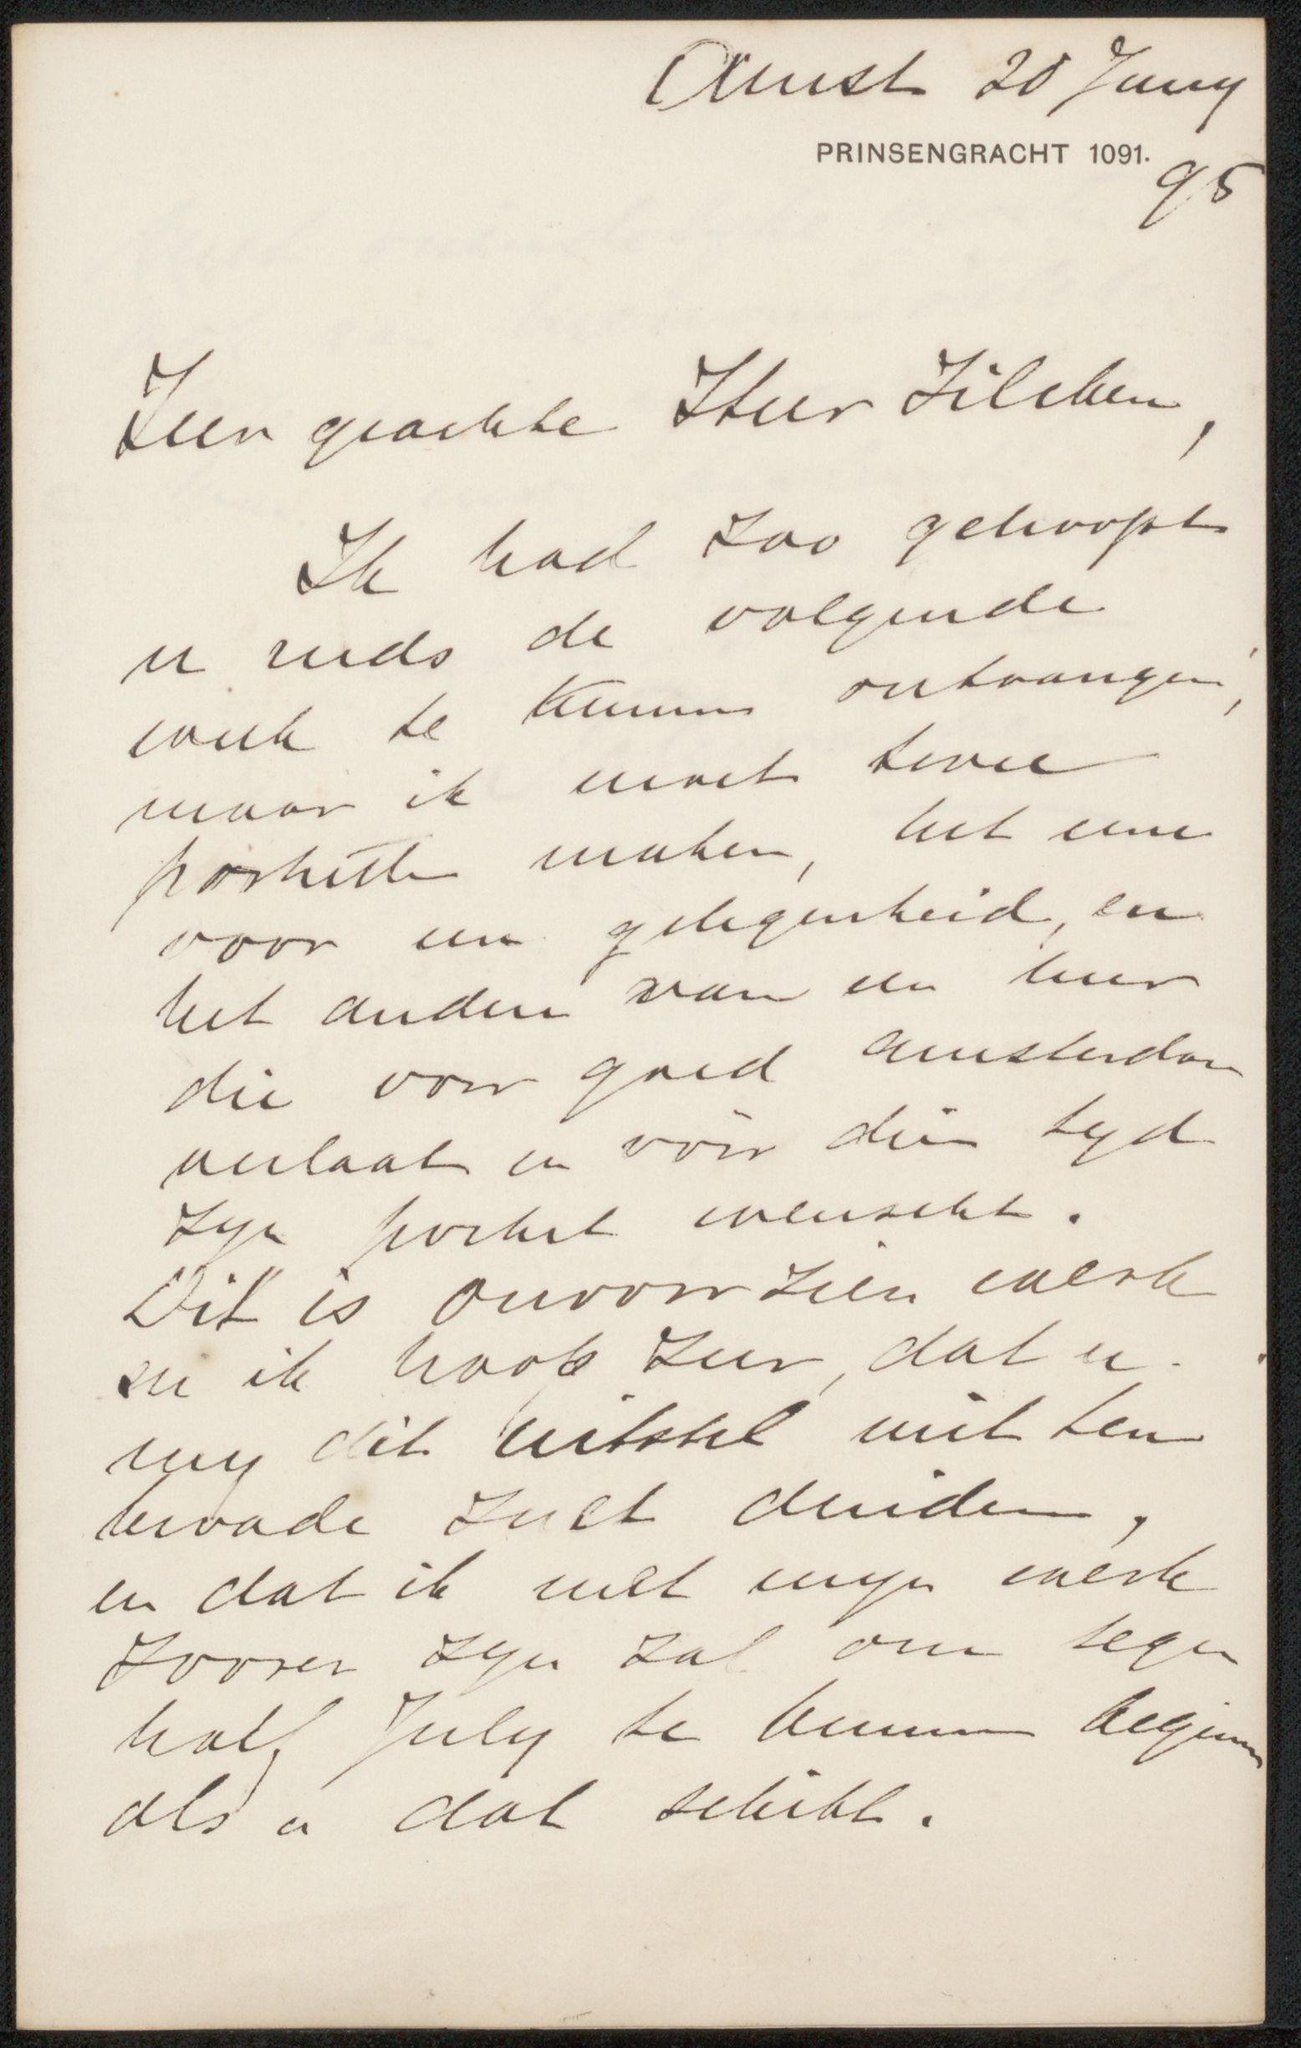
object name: letter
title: Brief aan Philip Zilcken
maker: thérèse schwartze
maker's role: draughtsman, painter, print maker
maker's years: 1851-1918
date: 1895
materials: ink, paper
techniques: pen, printing, writing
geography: amsterdam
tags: voorburg, renée hélène laure zilcken, the hague, painter, philip zilcken, anonymous historical person portrayed, historical persons (portraits and scenes from the life), amsterdam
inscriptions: collector's mark: ‘RPK’